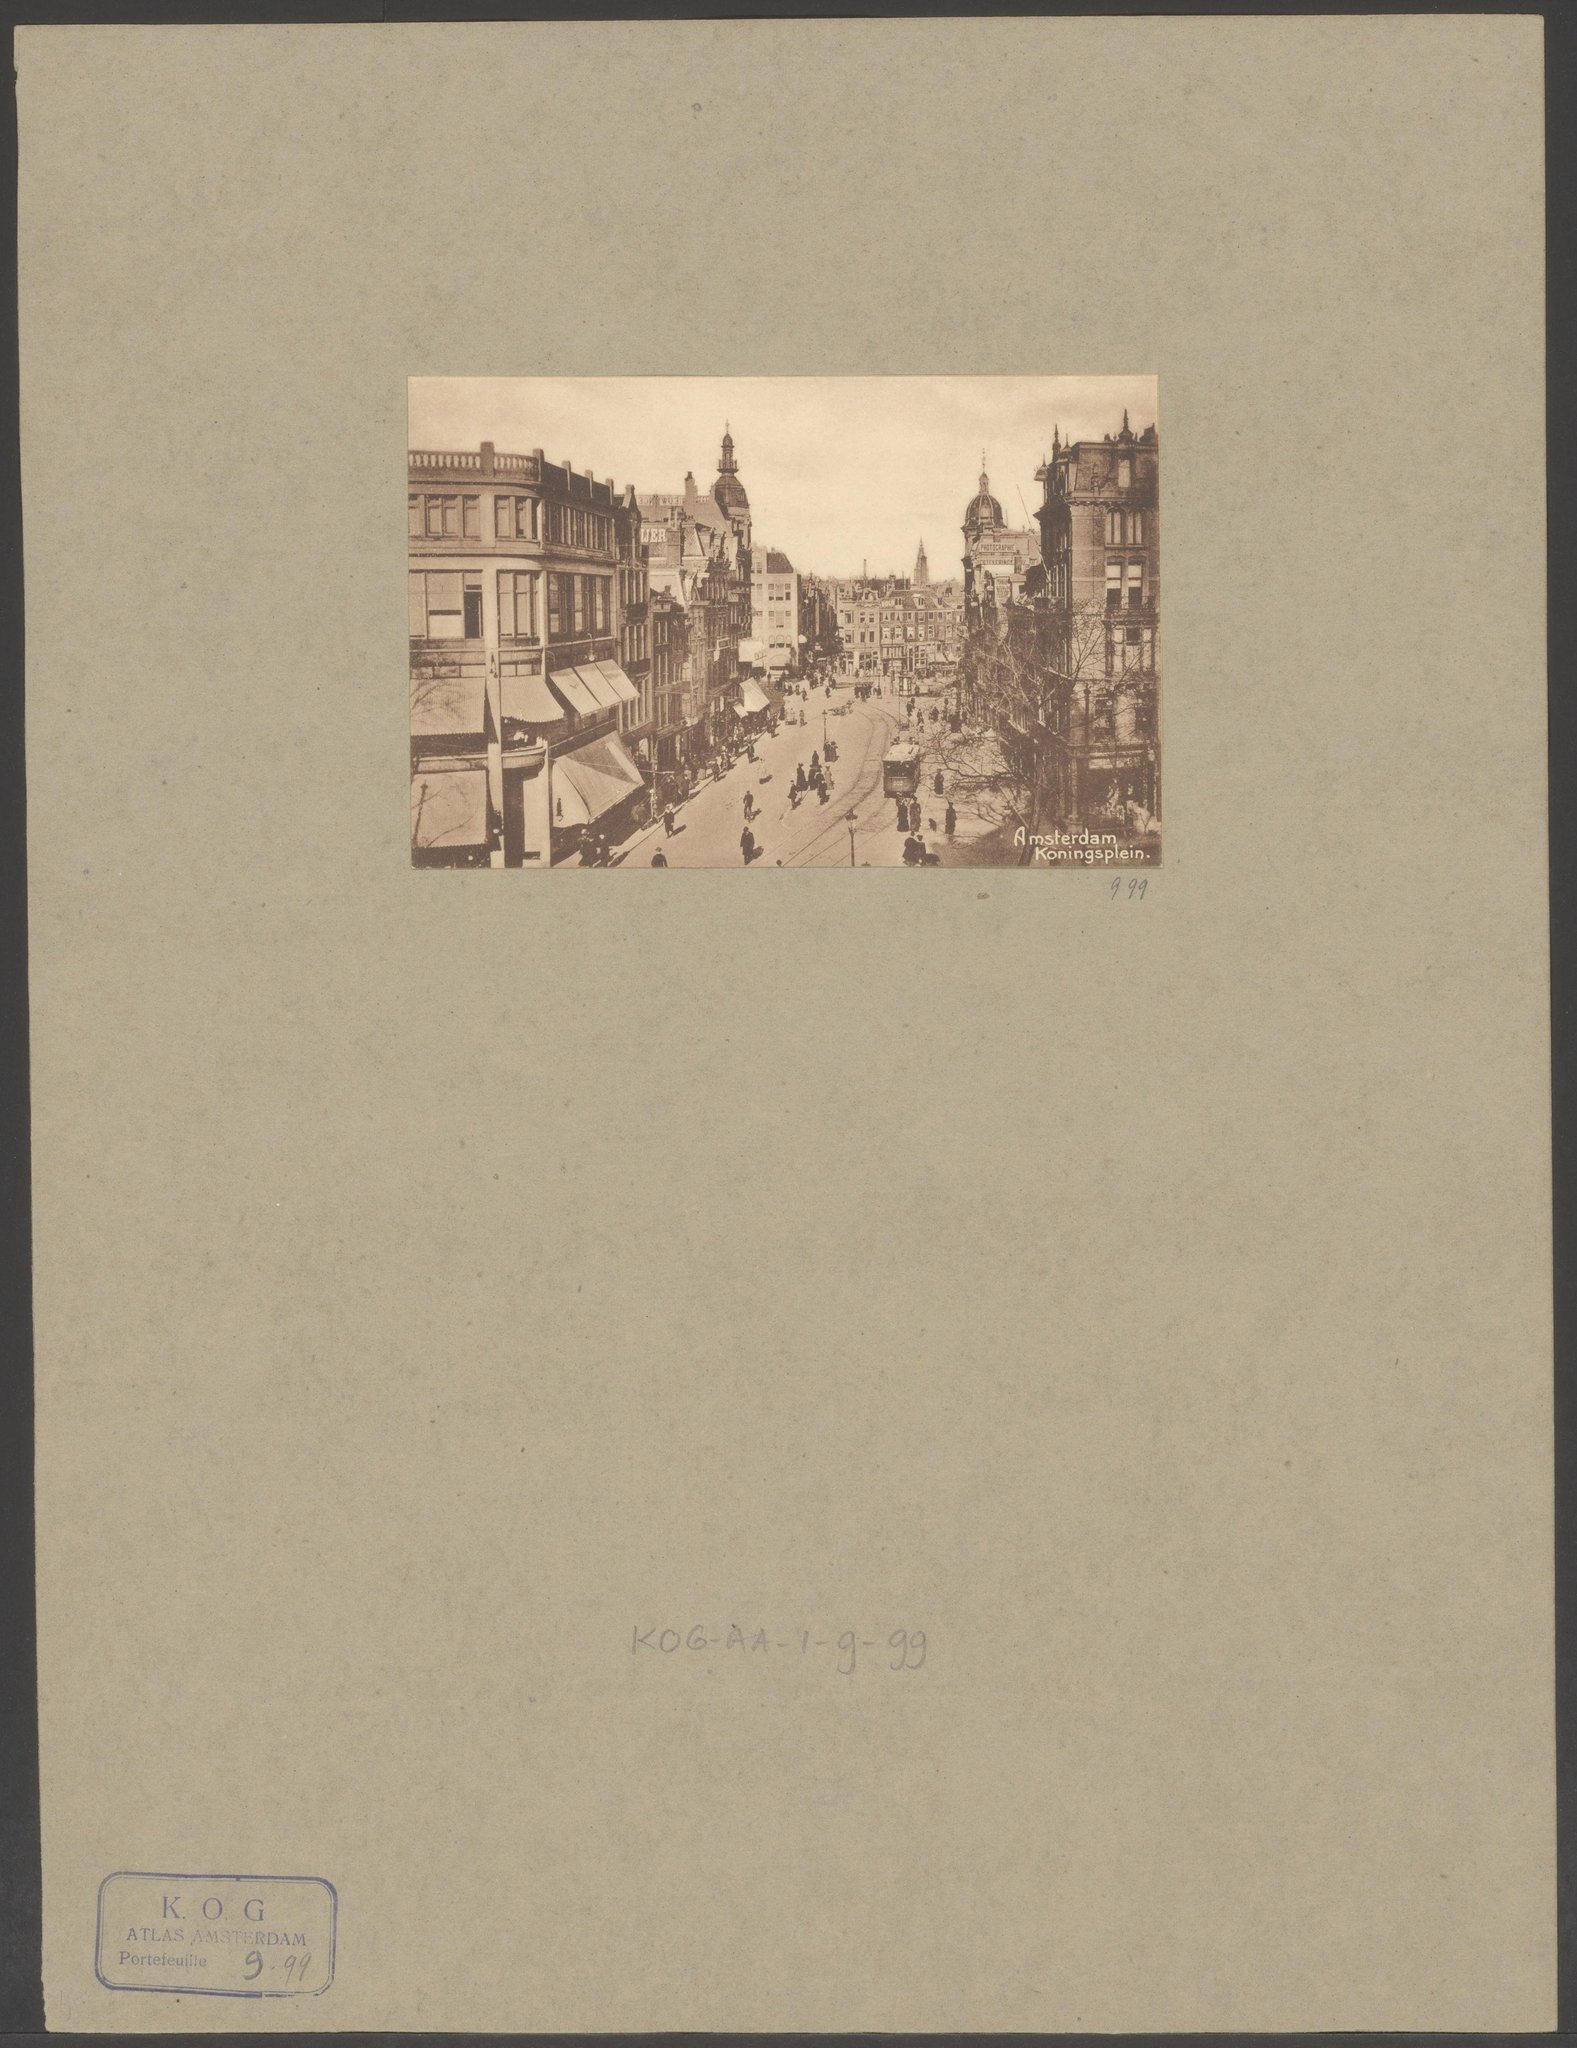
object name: photomechanical print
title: Gezicht op het Koningsplein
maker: Anonymous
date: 1875-1930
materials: cardboard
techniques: photograph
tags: square, place, circus, etc., tramway, tram, city-view in general; 'veduta', street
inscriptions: collector's mark: ‘9.99’ Lugt 1641b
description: Onderwerpsrubriek binnen de Atlas Amsterdam: Kadijksplein, Karthuizerkerkhof, Kattegat, Kattenburg, Kapelsteeg O.Z., Enge Kerksteeg, Kerkstraat, Kinkerstraat, Kolk O.Z., Koningsplein, Kromboomsloot [Krom Boomssloot], Kostverlorenkade, Kwakersdwarspad, Kalverstraat, Keizersgracht (v.d. Brouwersgracht – Amstel), Klerensloot (Gedempte), Klimopstraat, Kloveniersburgwal, Kraansluis.